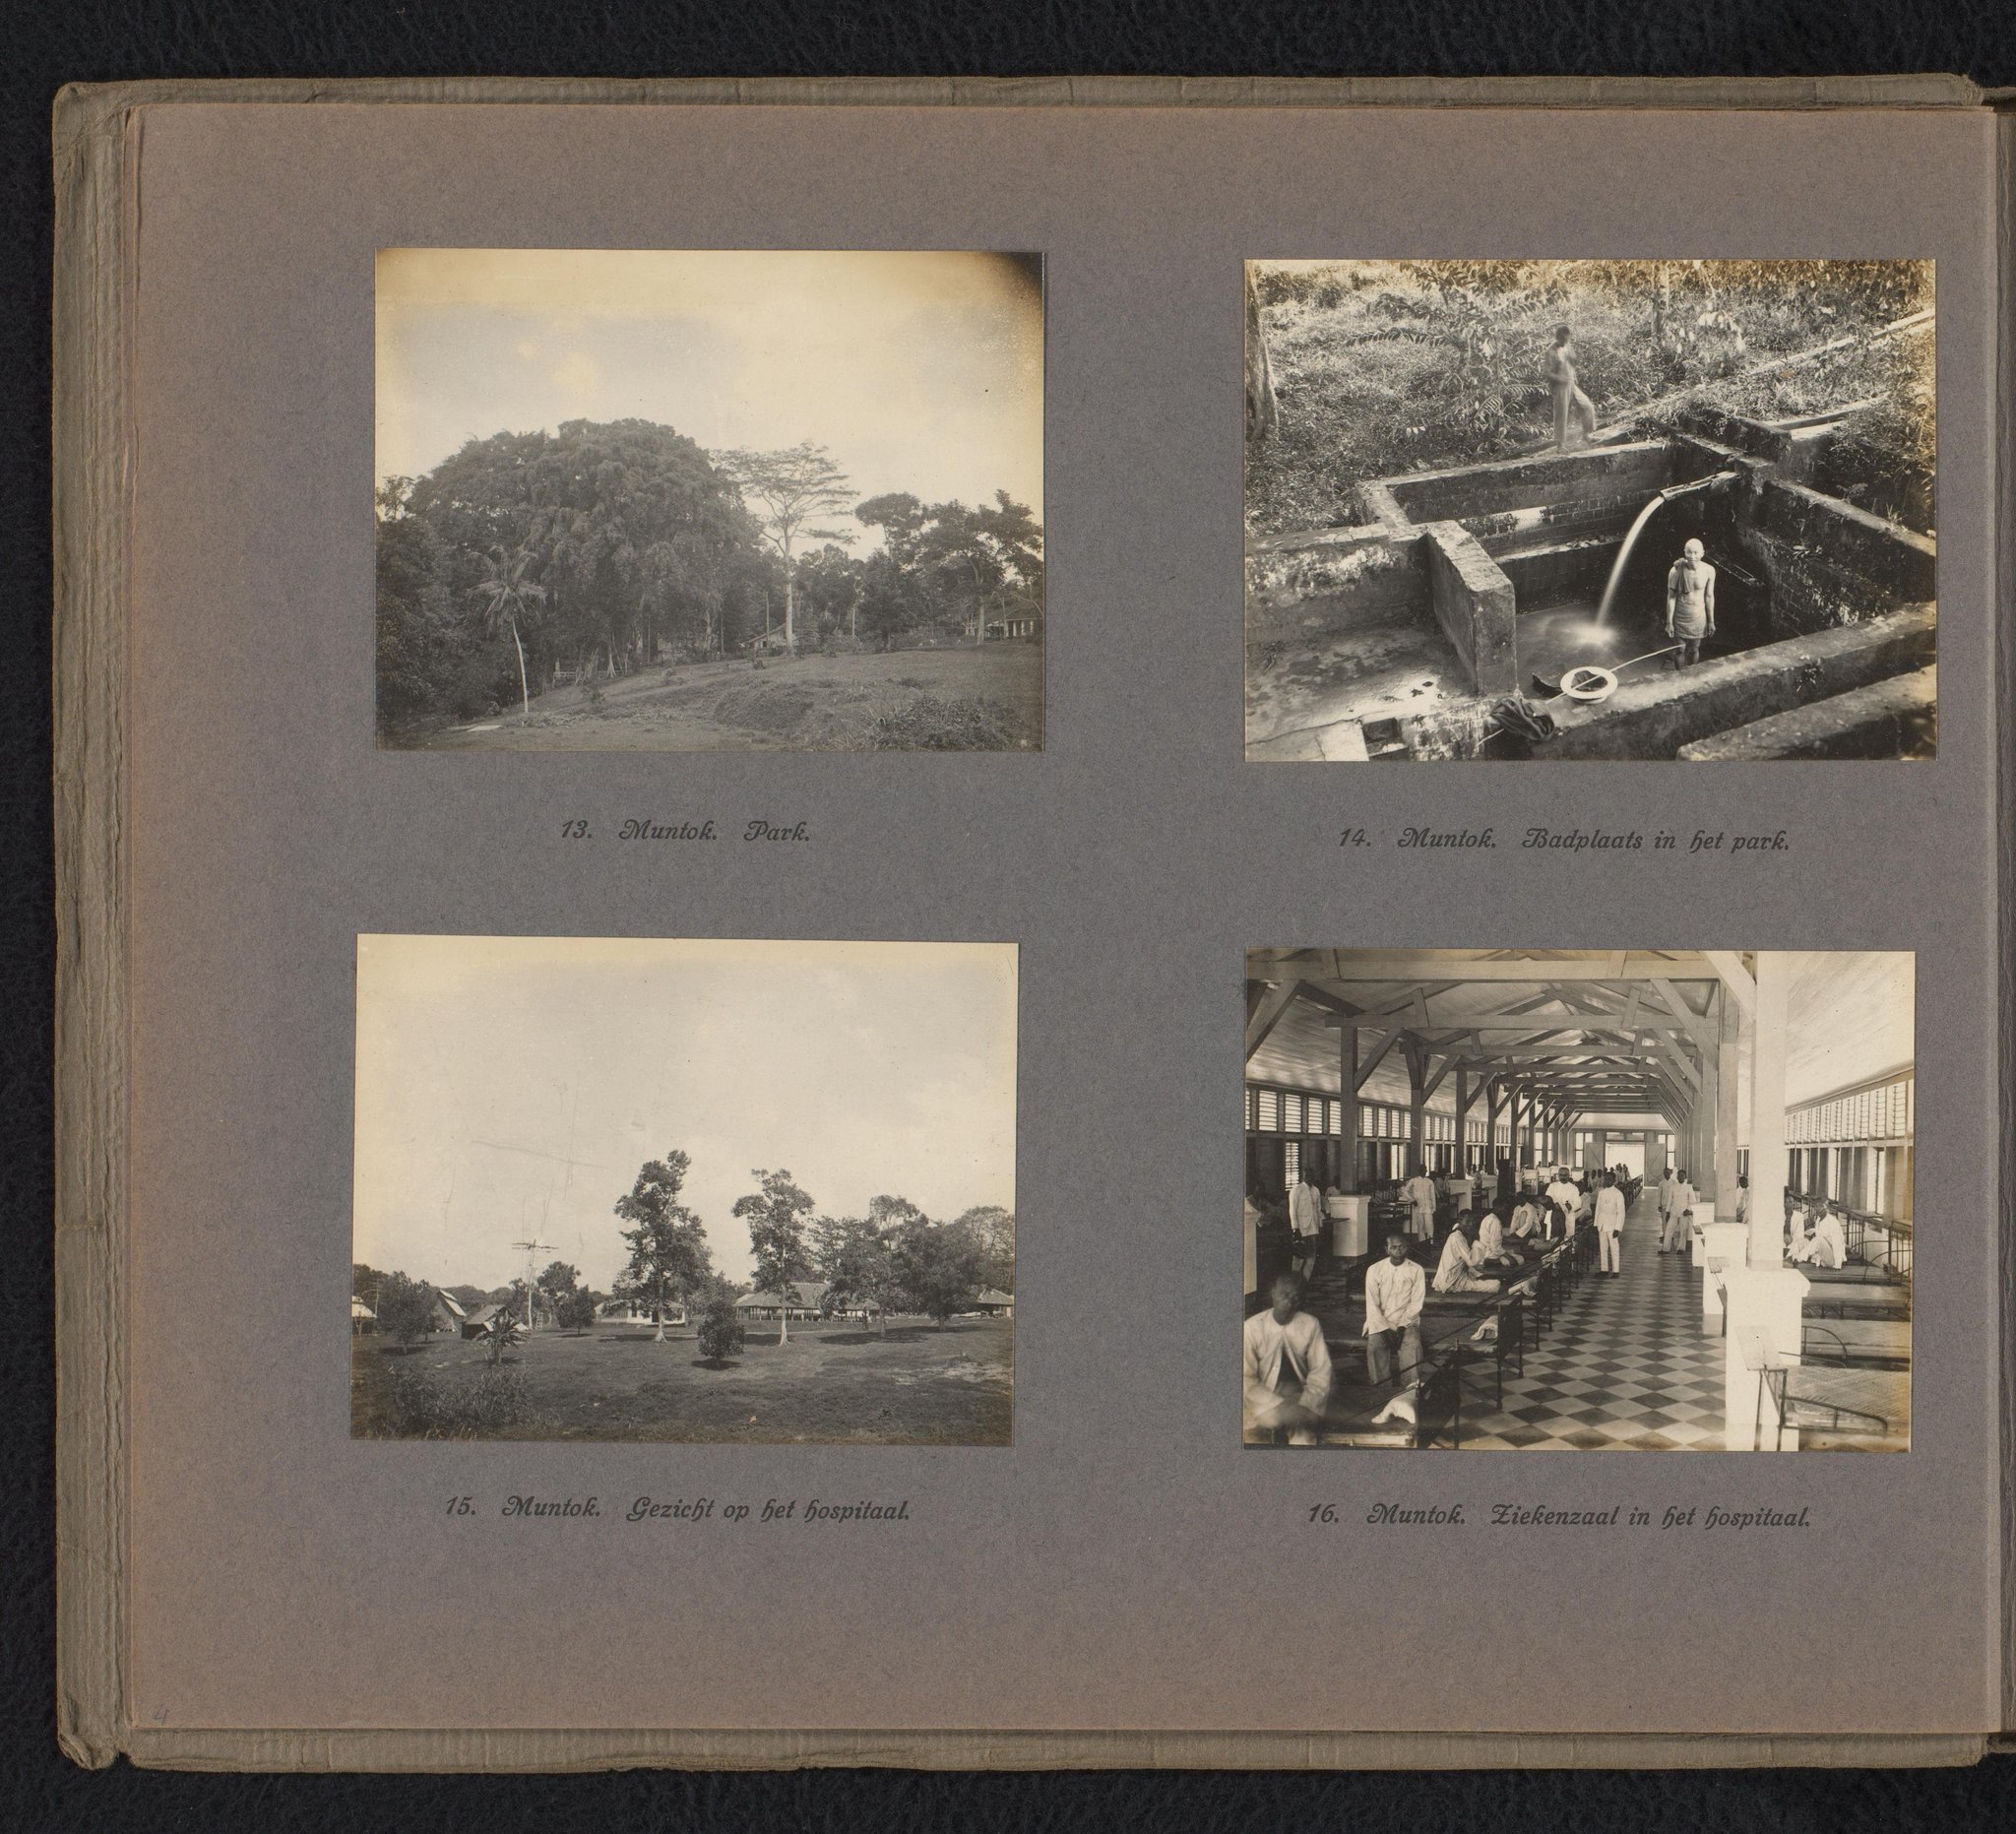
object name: photograph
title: Gezichten te Muntok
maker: Anonymous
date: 1907-1919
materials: cardboard, photographic support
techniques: gelatin silver print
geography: bangka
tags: robert julius boers, colonial system, landscapes in tropical and sub-tropical regions, hospital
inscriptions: inscription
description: Albumblad met vier foto's genummerd 13-16 met diverse gezichten te Muntok op Banka: park en ziekenhuis. Onderdeel van het Banka-Album met foto's over het eiland Banka en de tinwinning door het staatsbedrijf de Banka-tinwinning in de periode ca. 1907-1919.